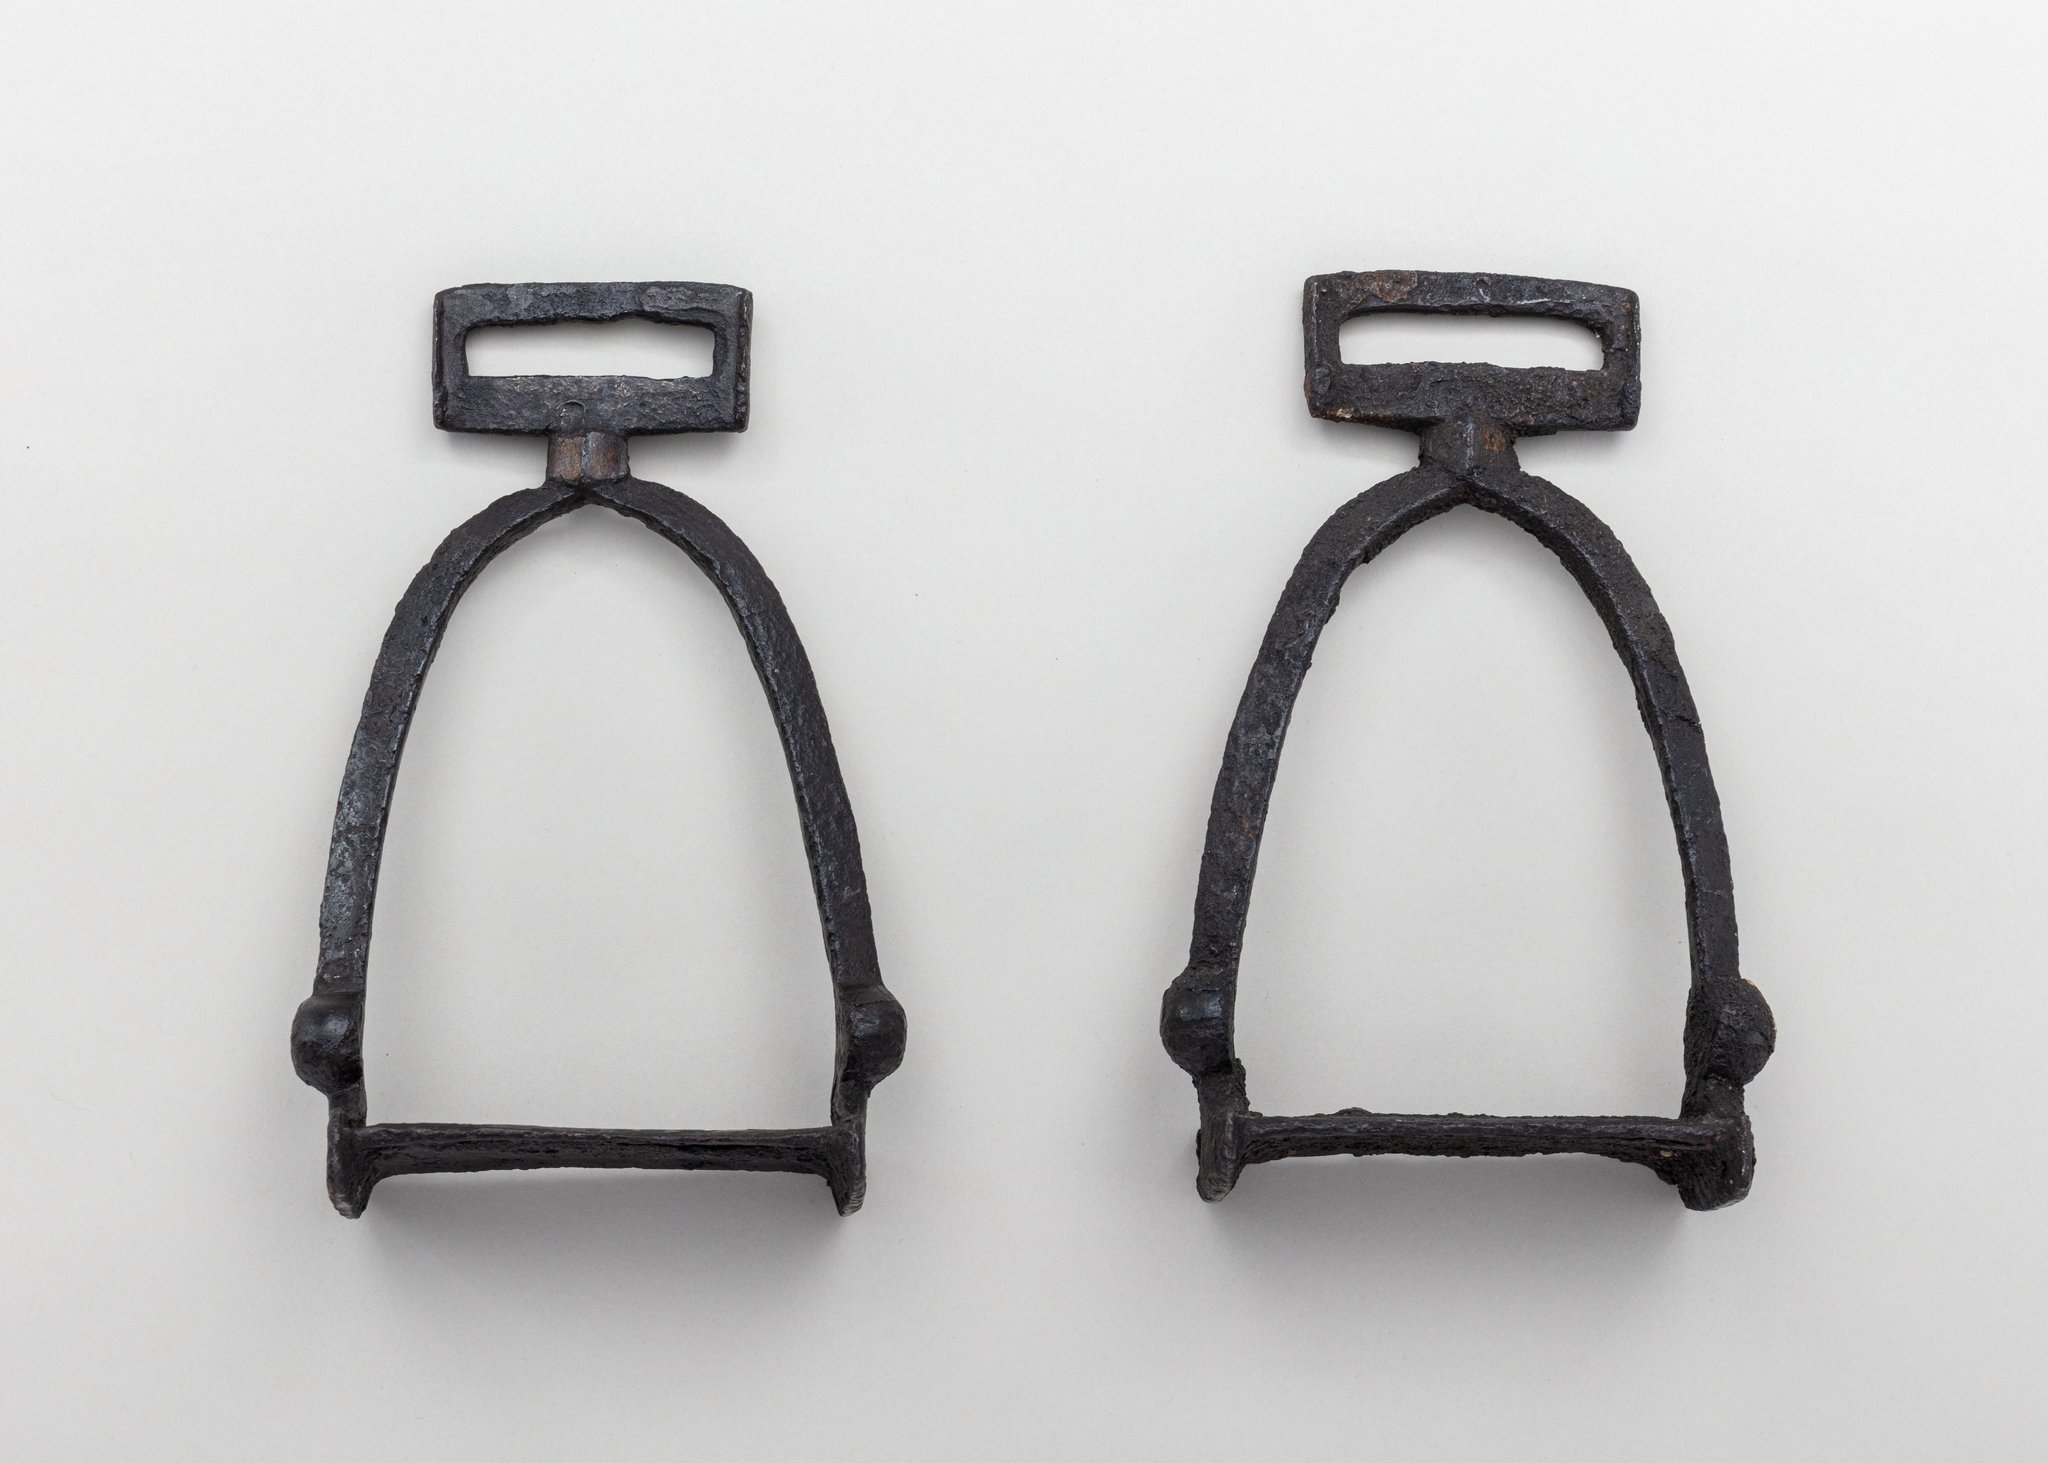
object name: pair of stirrup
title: Pair of Stirrups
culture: scandinavian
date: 967-1033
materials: bronze, gold, iron, silver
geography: denmark